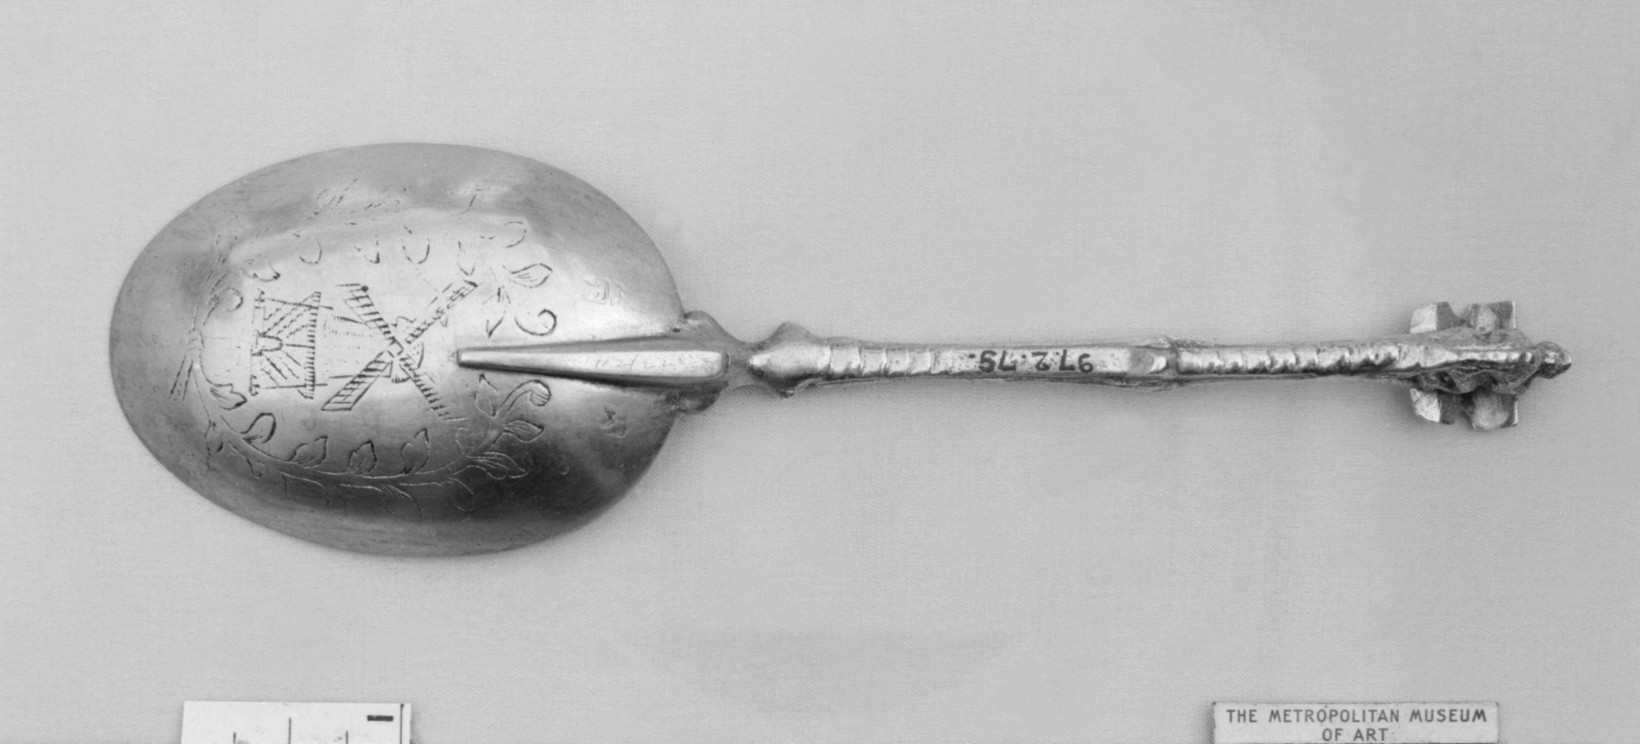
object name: spoon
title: Shield-top spoon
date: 1851-1900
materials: silver gilt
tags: shields